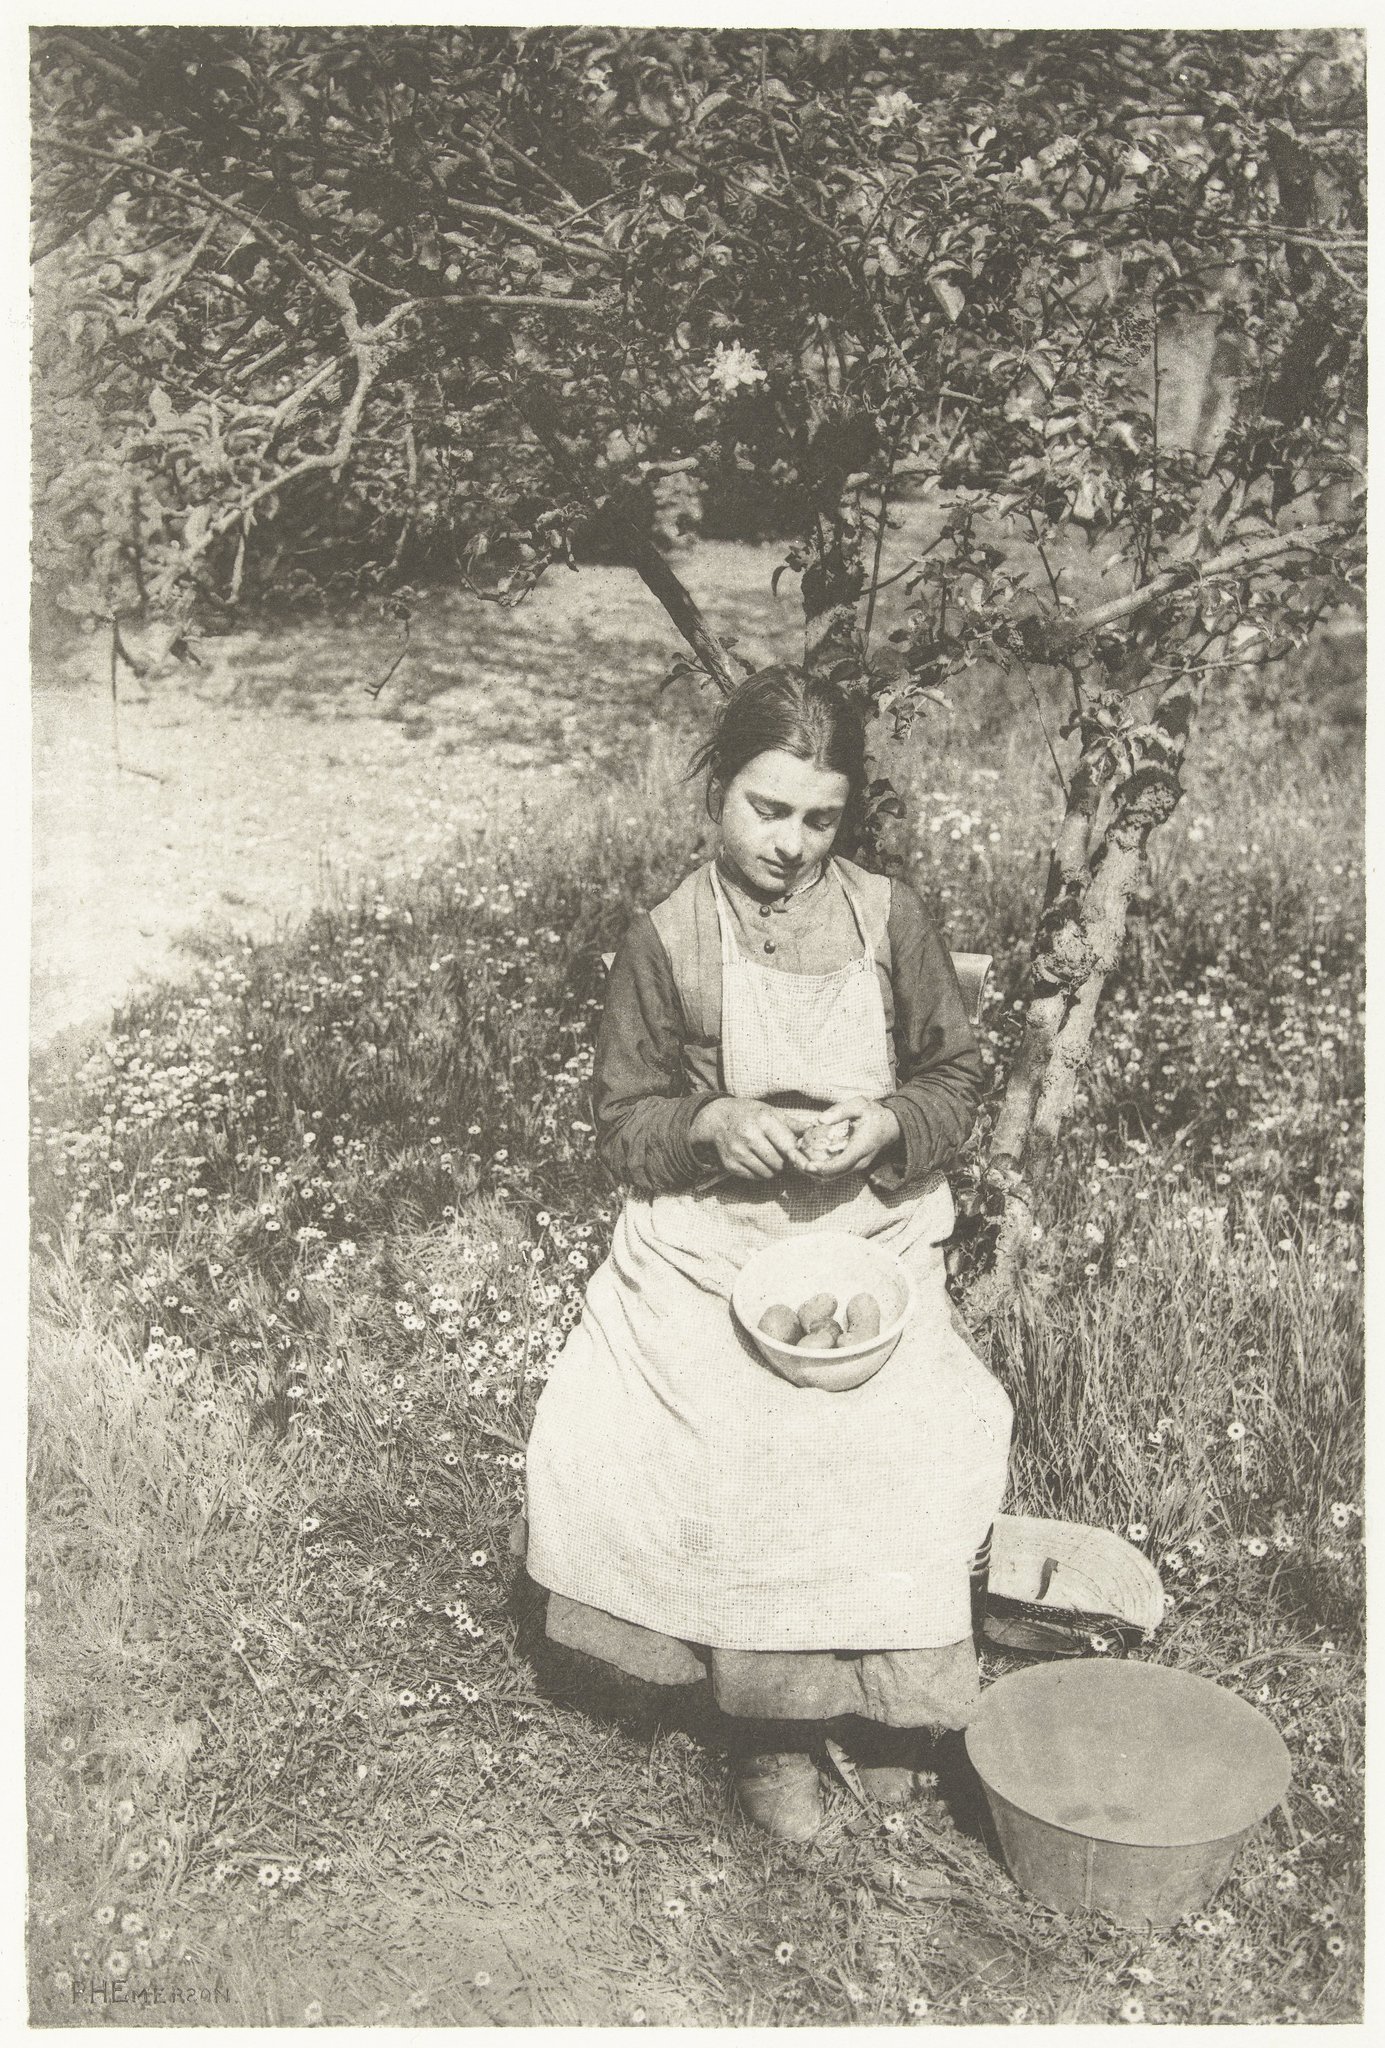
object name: photograph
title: A spring Idyl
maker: peter henry emerson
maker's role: fotograaf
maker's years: 1856-1936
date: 1887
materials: cardboard, paper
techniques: photoaquatint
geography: england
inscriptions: signature: ‘P.H. Emerson.’